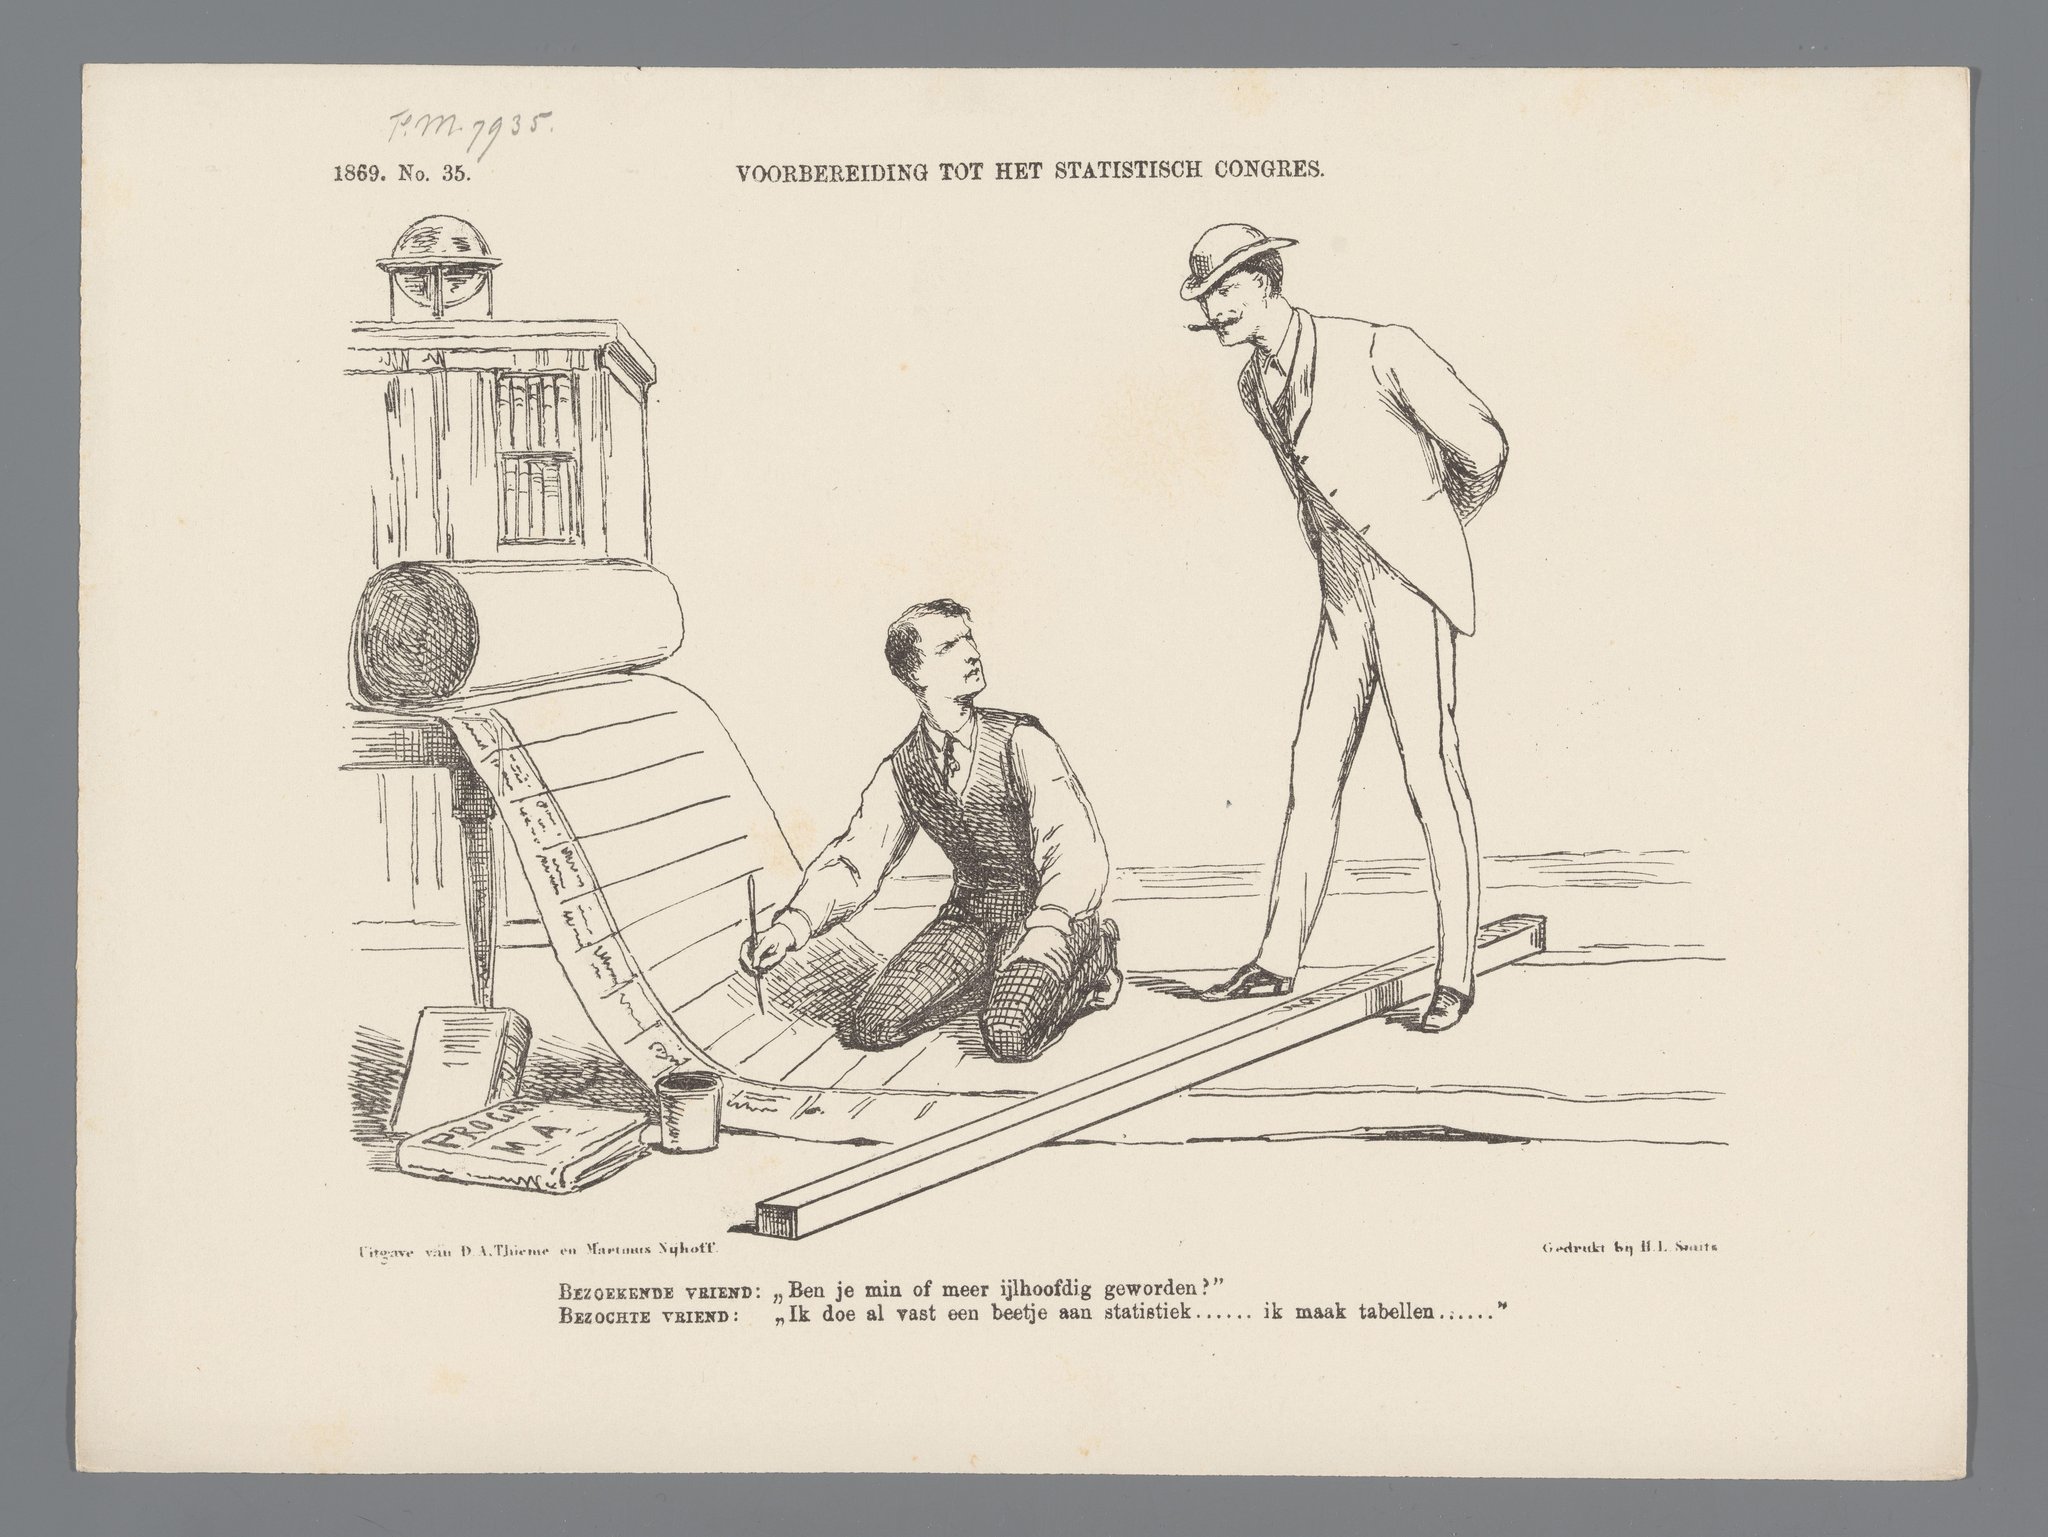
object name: cartoon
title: Spotprent op het Statistisch Congres, 1869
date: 1869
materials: paper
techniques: lithograph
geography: arnhem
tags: algebra and statistics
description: Spotprent op het Statistisch Congres. Een statisticus maakt een tabel ter voorbereiding op het congres. Plaat verschenen bij het weekblad De Nederlandsche Spectator, nr. 35, 1869.